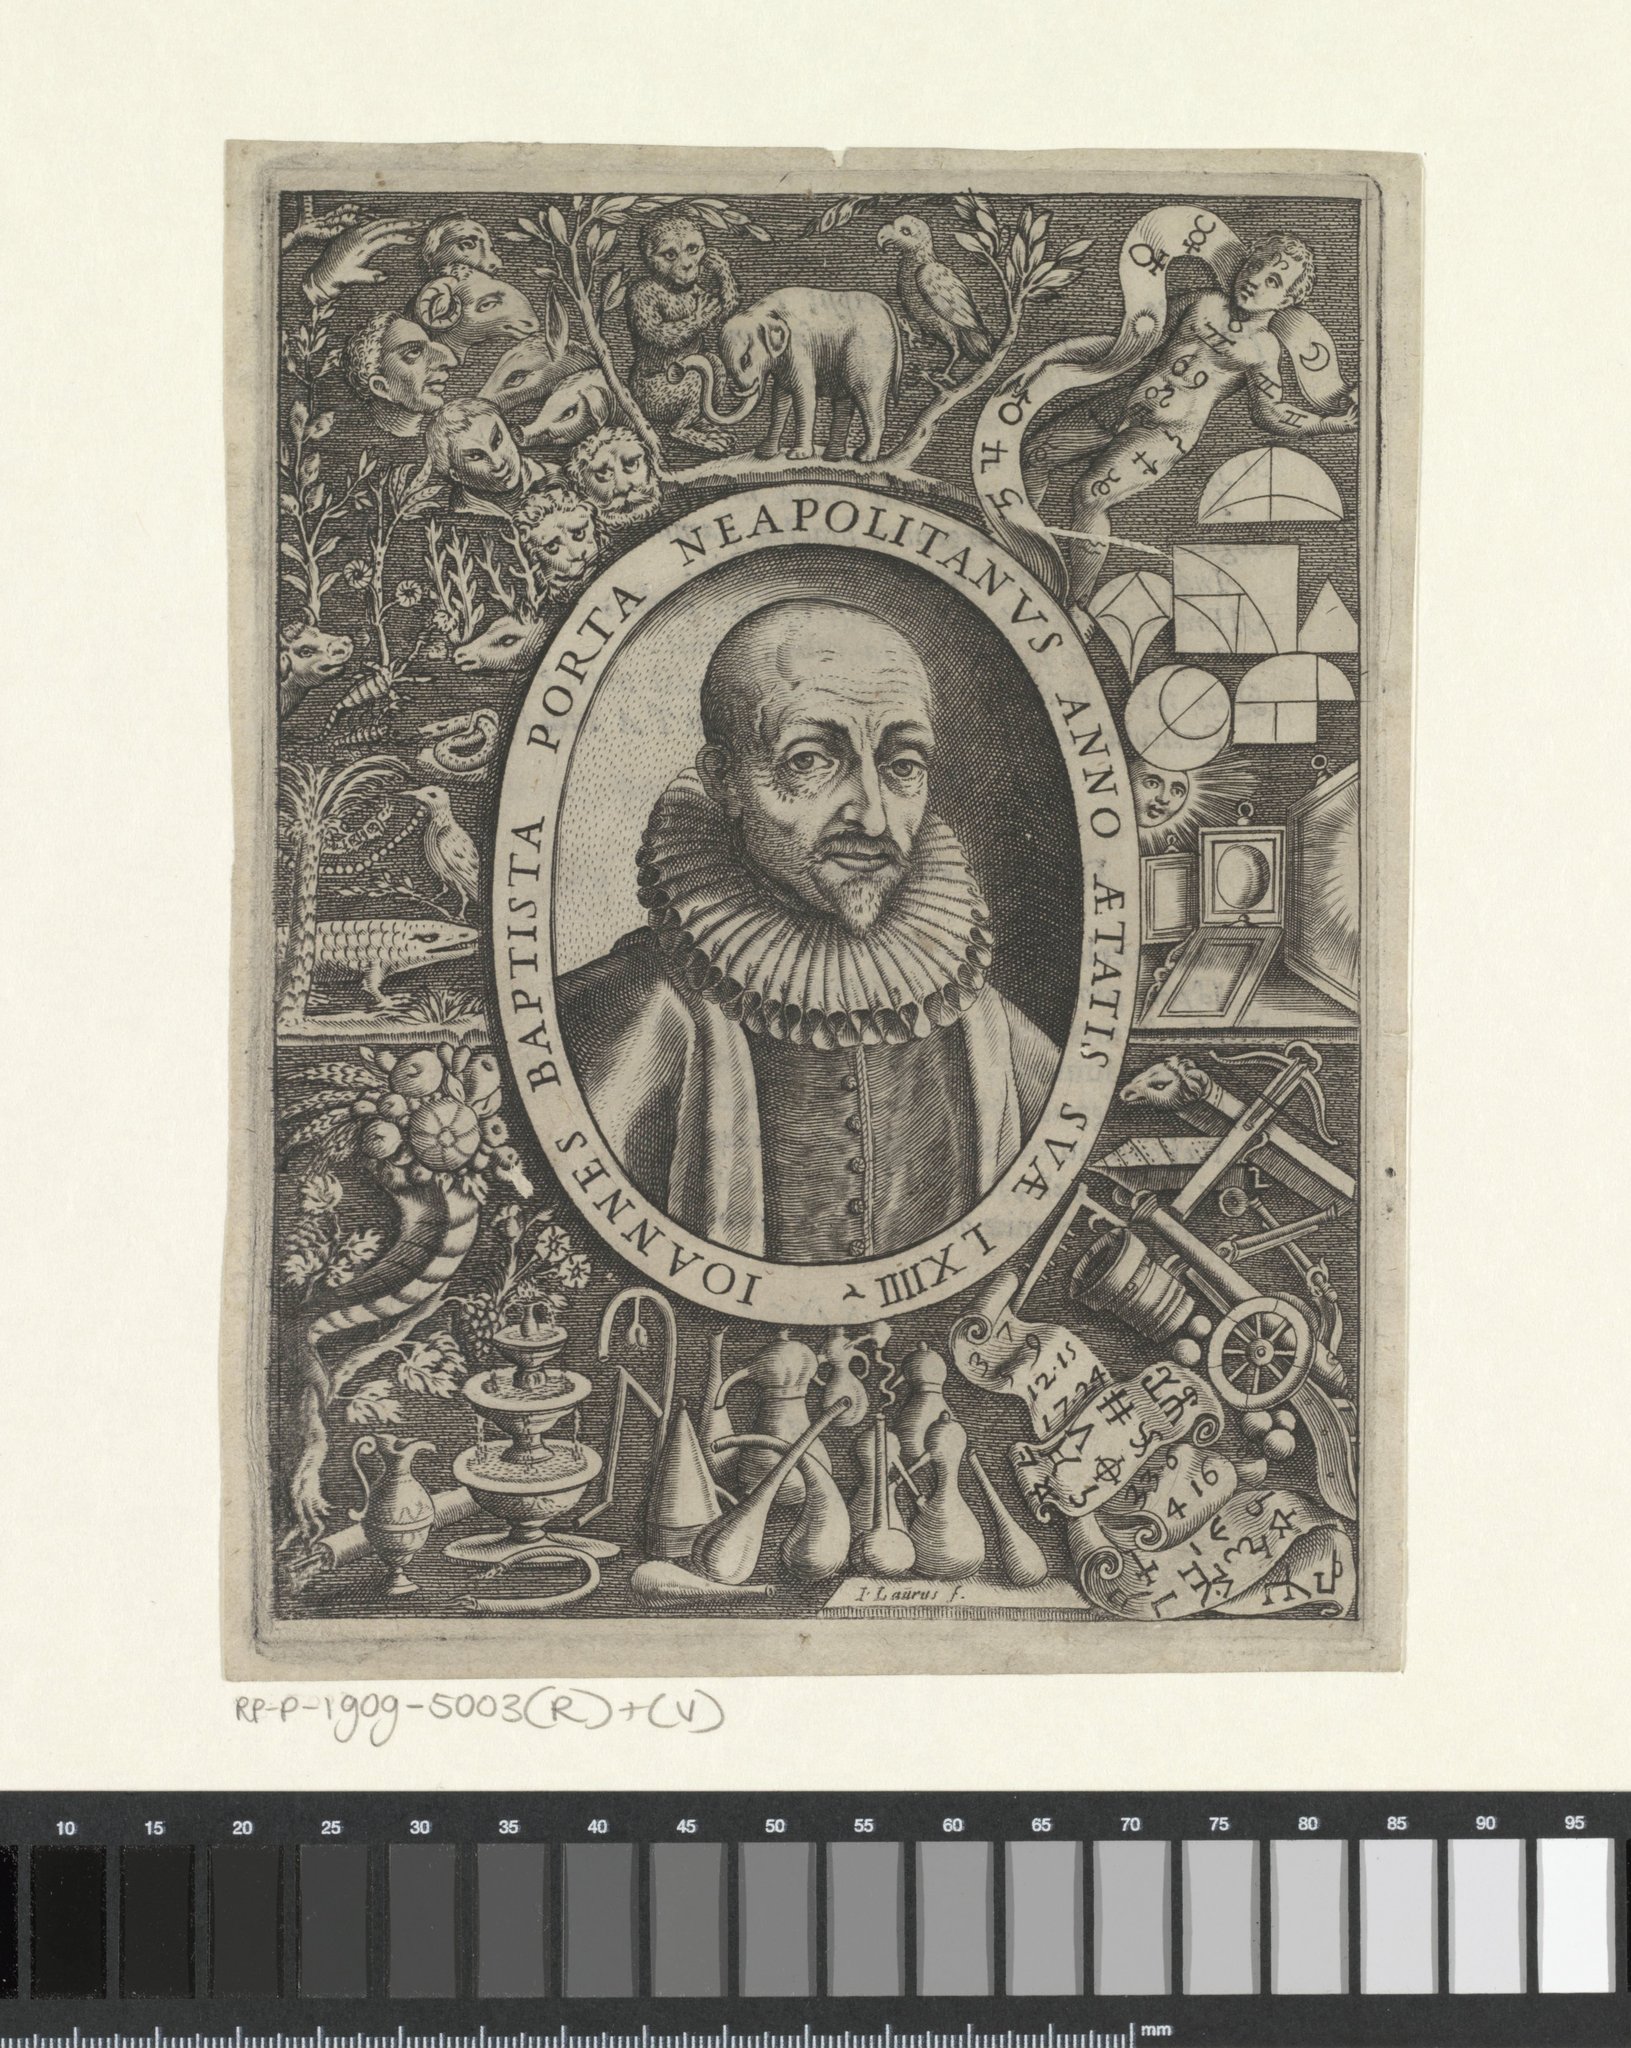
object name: print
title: Portret van wetenschapper en toneelschrijver Giambattista della Porta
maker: jacobus laurus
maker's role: print maker, publisher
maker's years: 1561-1645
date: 1584-1637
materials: paper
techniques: engraving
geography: italy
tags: naples, historical persons, writer, poet, author, science and technology (+ portrait of scholar, scientist)